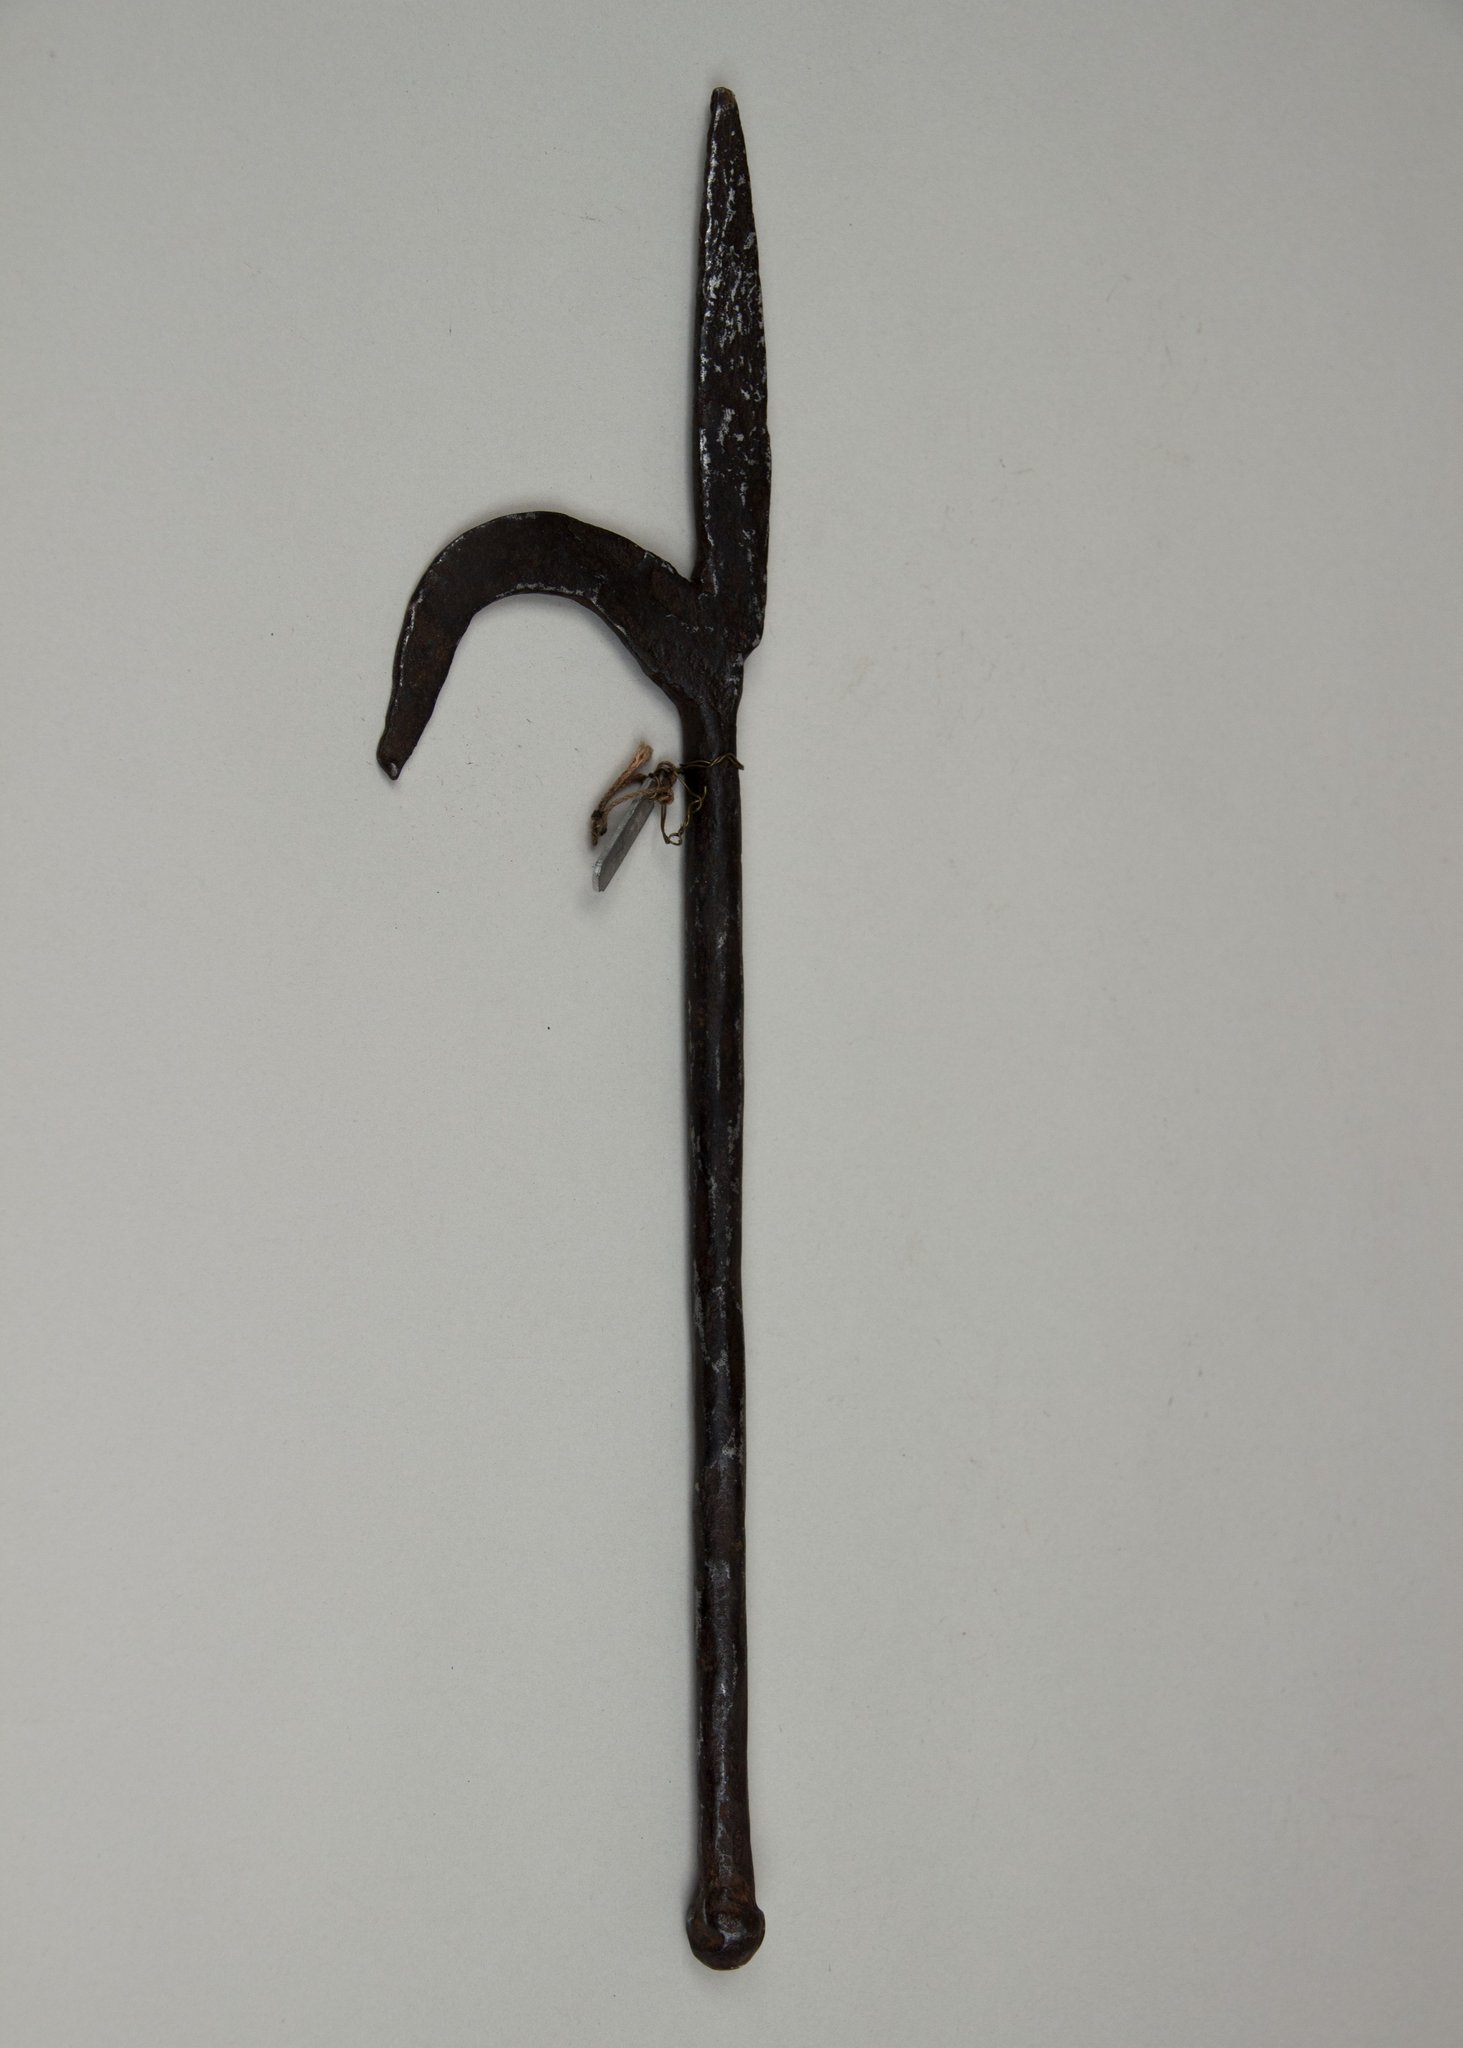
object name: ancus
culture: indian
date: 1801-1900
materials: iron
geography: india